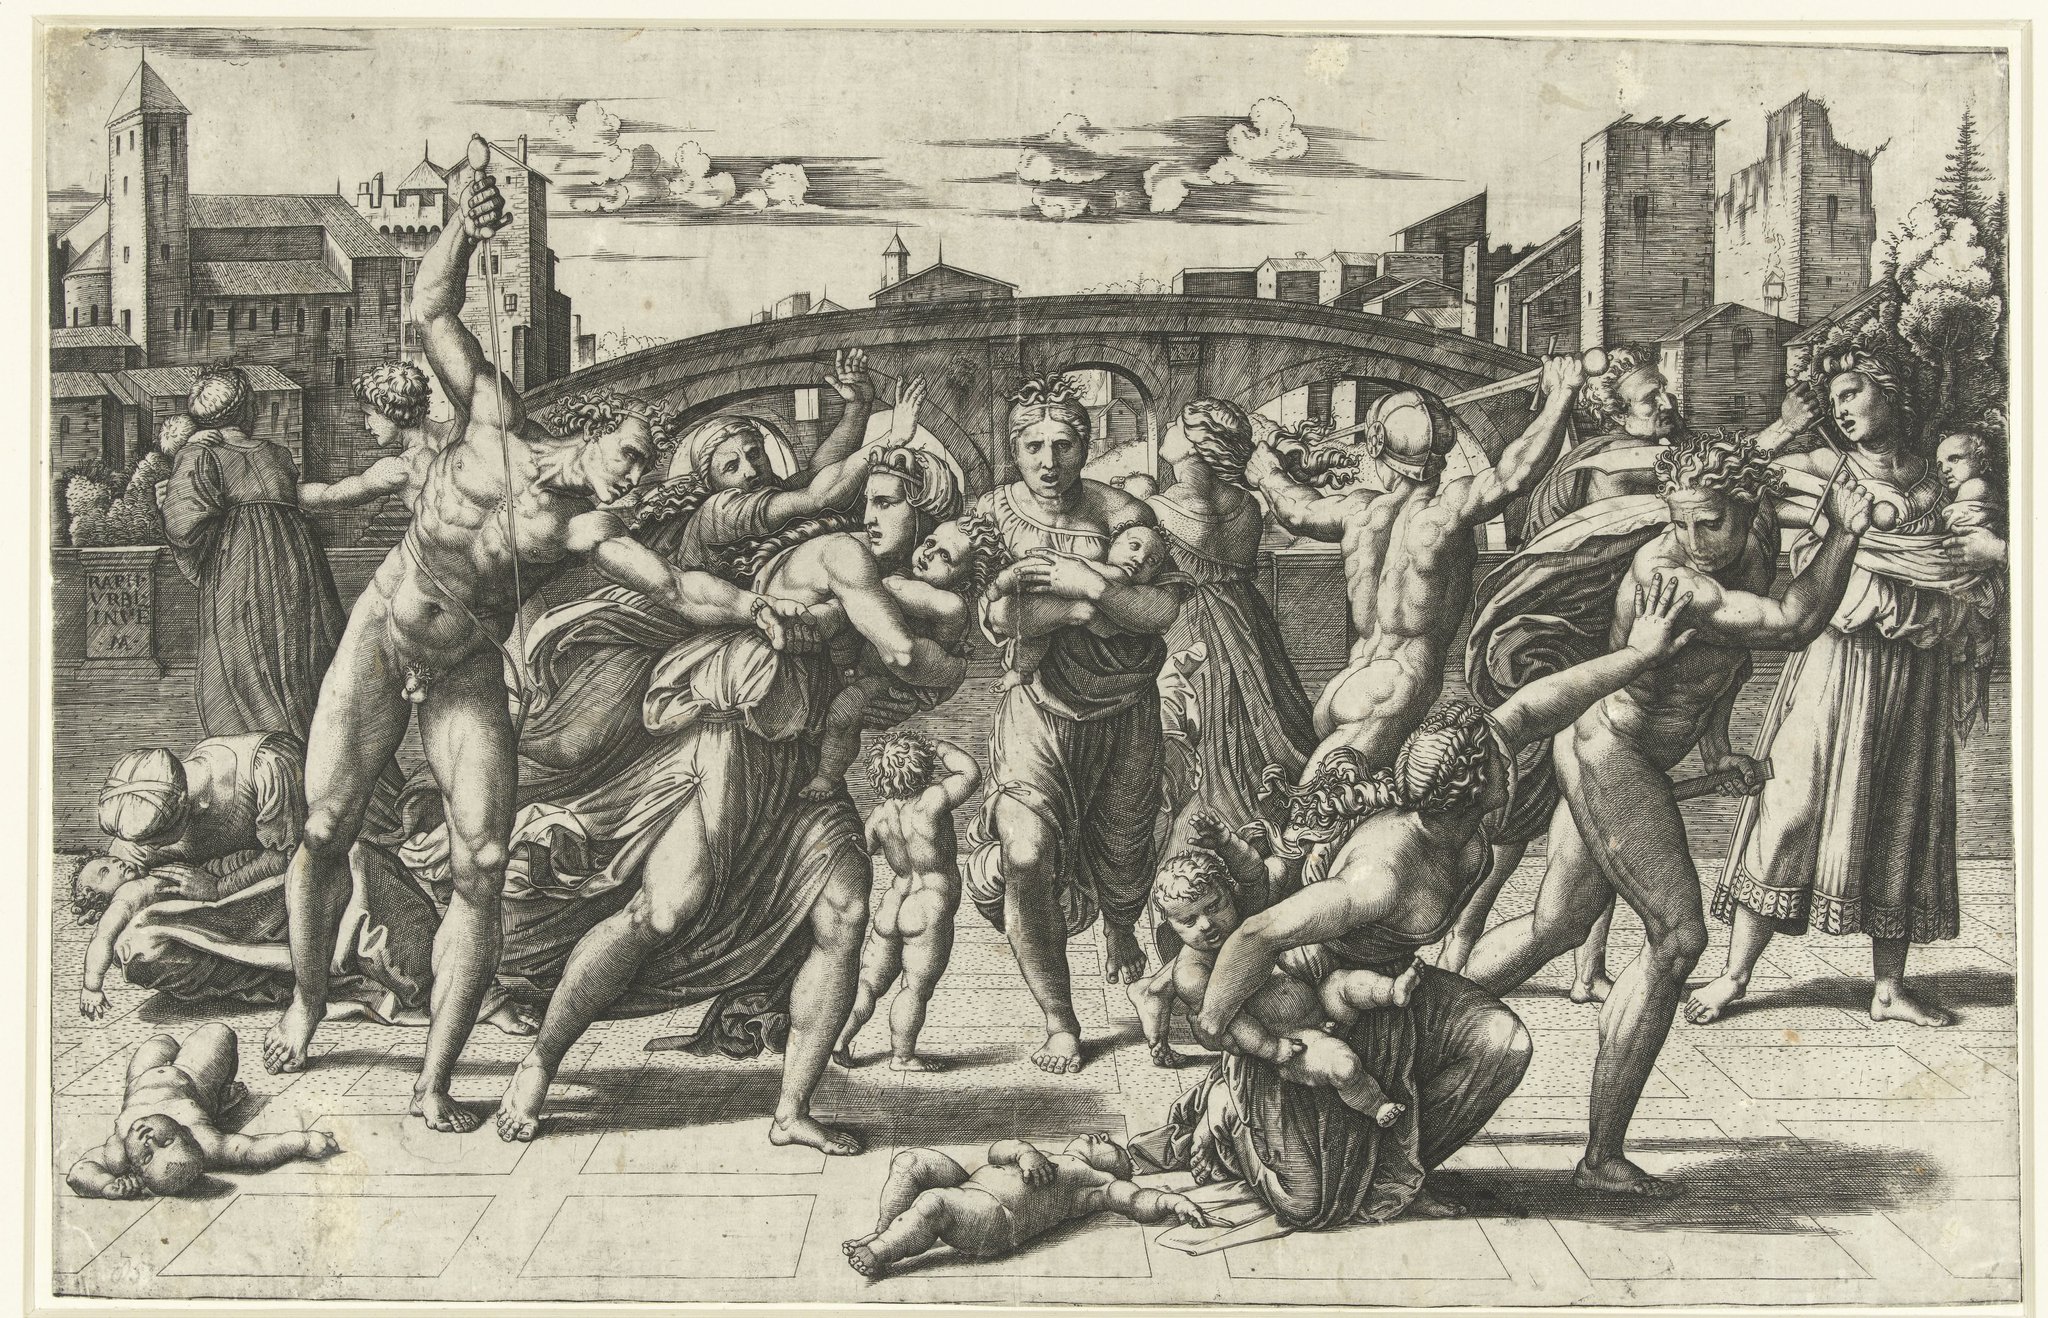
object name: print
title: Massacre of the Innocents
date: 1511-1512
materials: paper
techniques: engraving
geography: italy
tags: the massacre of the innocents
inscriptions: collector's mark: Lugt 240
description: The mother running desperately towards us holding her child is the focus of this finely balanced composition. Other women and children are arranged around her, trying to escape from the naked soldiers. The tiled floor and the bodies of dead children create a spatial effect. Raphael prepared for this elegant, though gruesome ballet with numerous sketches, and engaged the expert engraver Marcantonio Raimondi to execute the design.